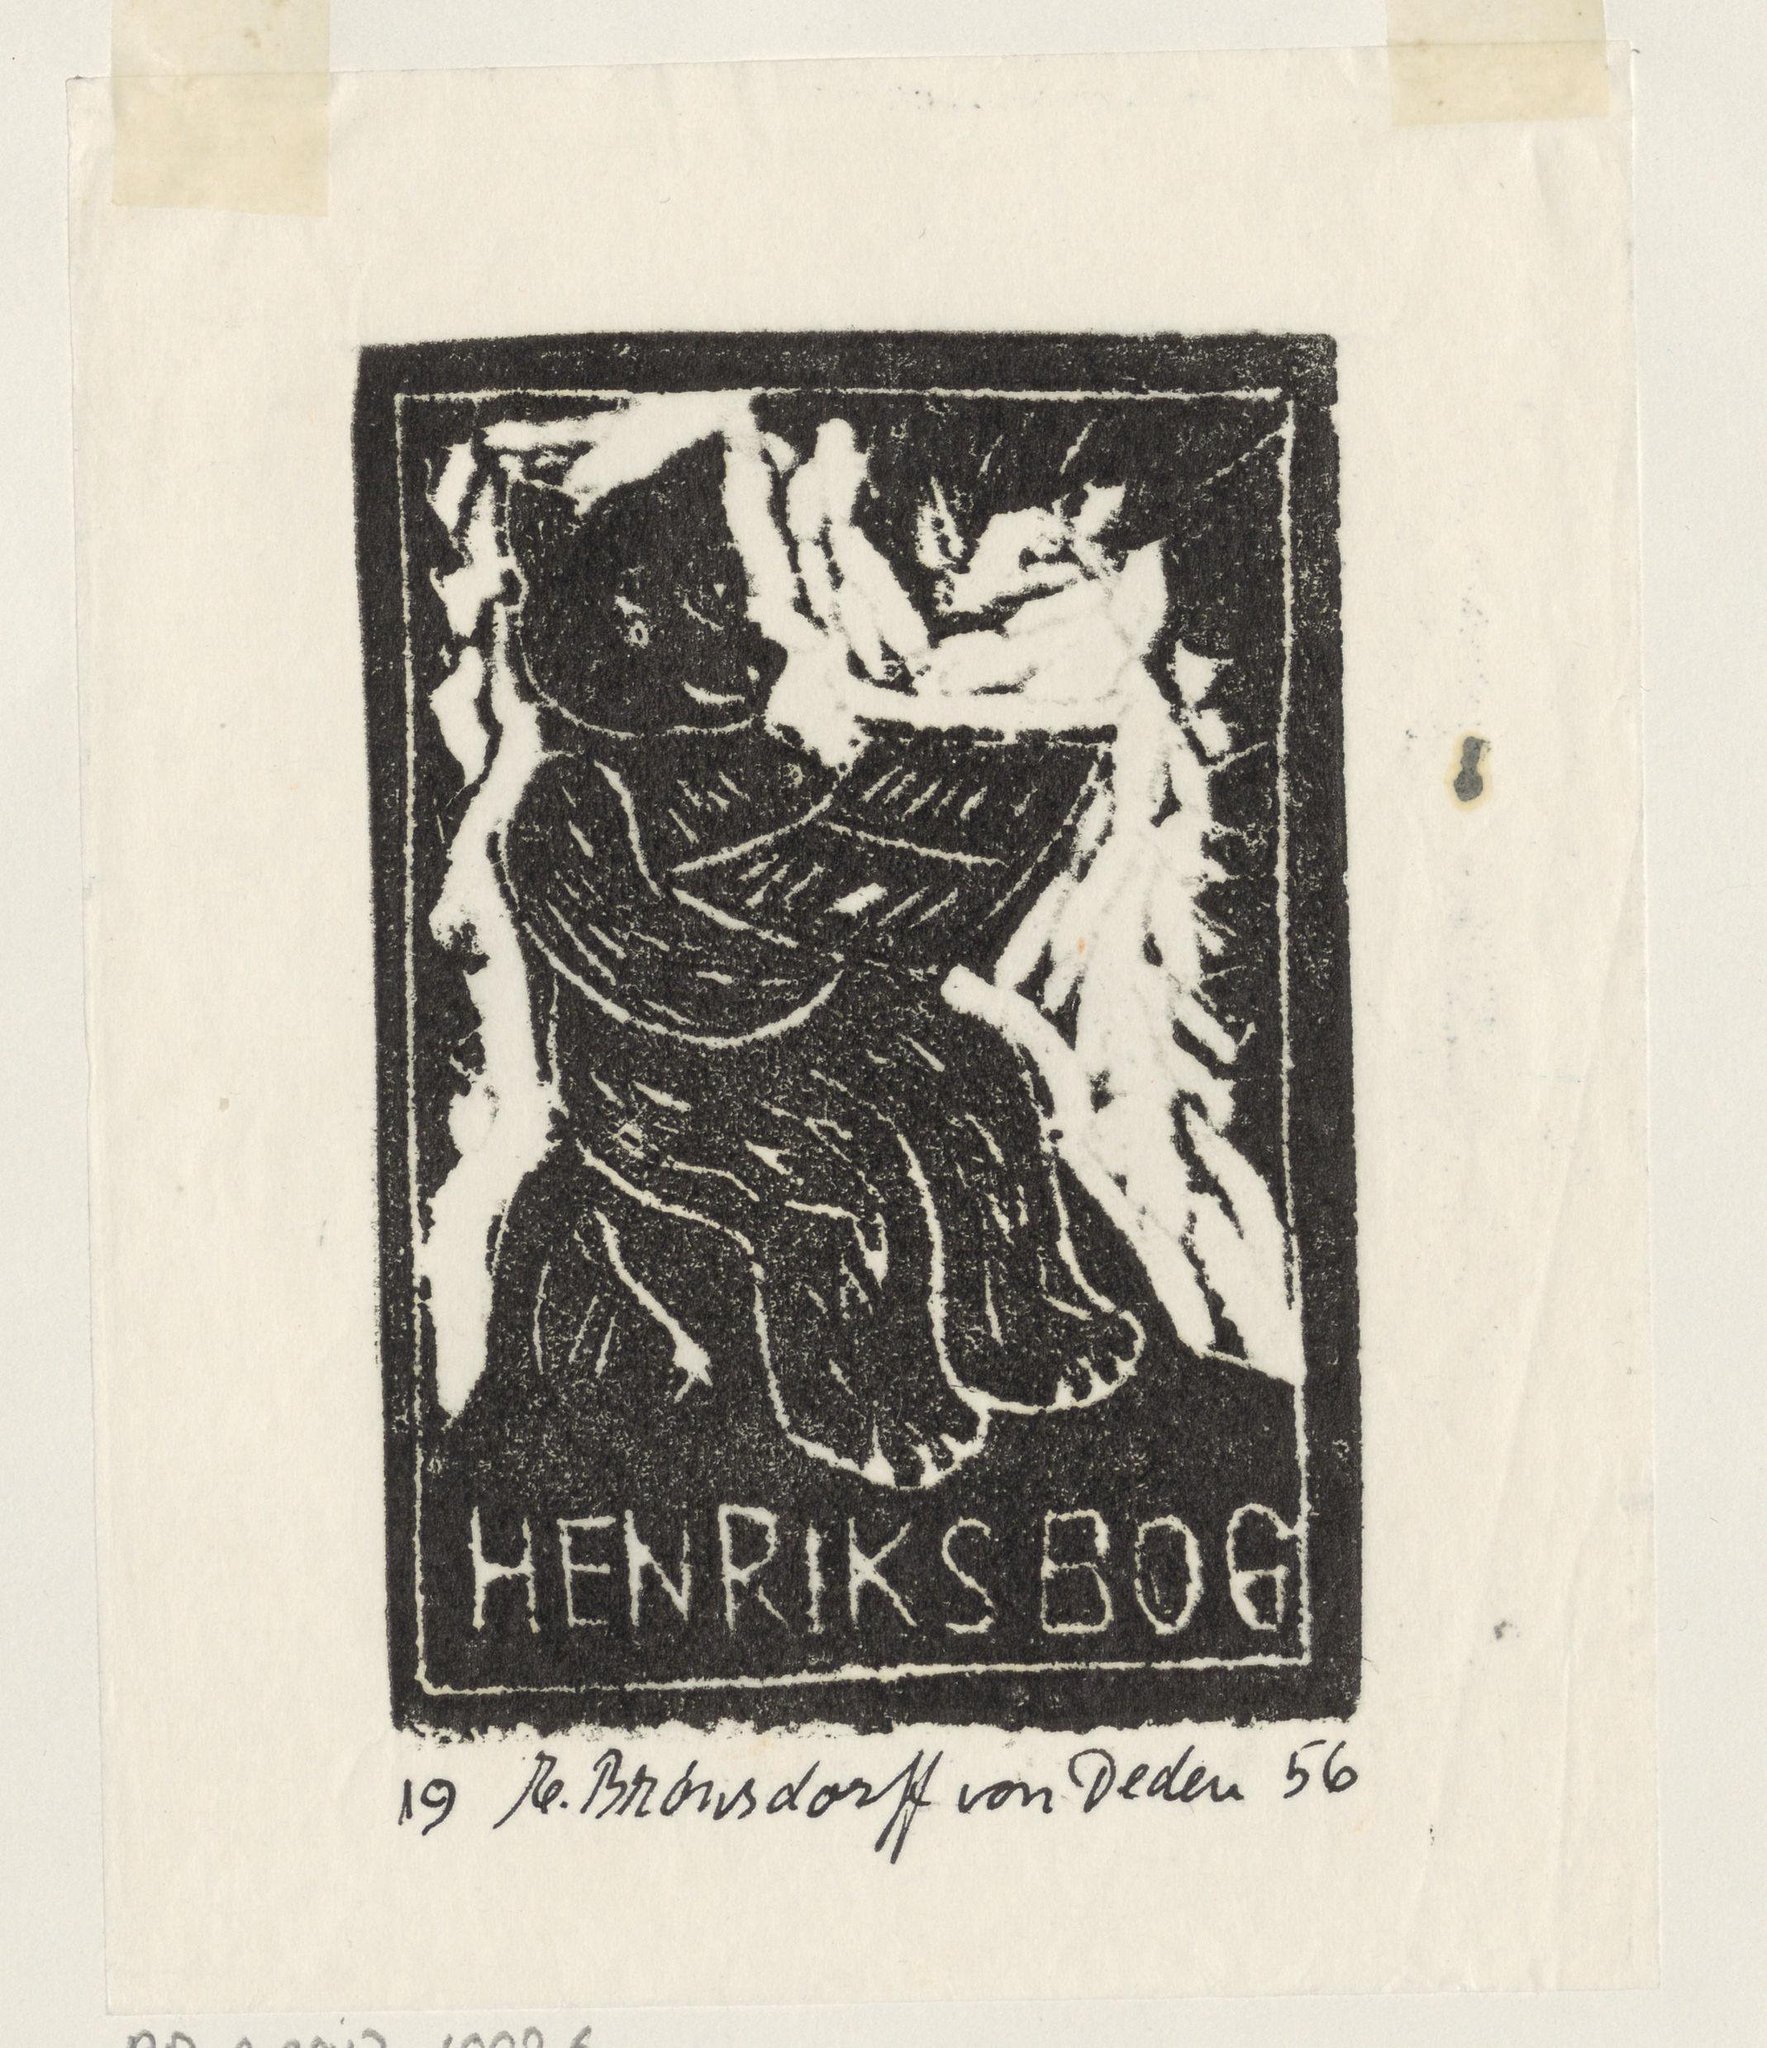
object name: bookplate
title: Ex libris van Henrik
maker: erik bronsdorff von deden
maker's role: print maker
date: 1956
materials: paper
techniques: linocut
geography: denmark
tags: reading, (playing with) toy animals, beasts of prey, predatory animals: bear, book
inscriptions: date